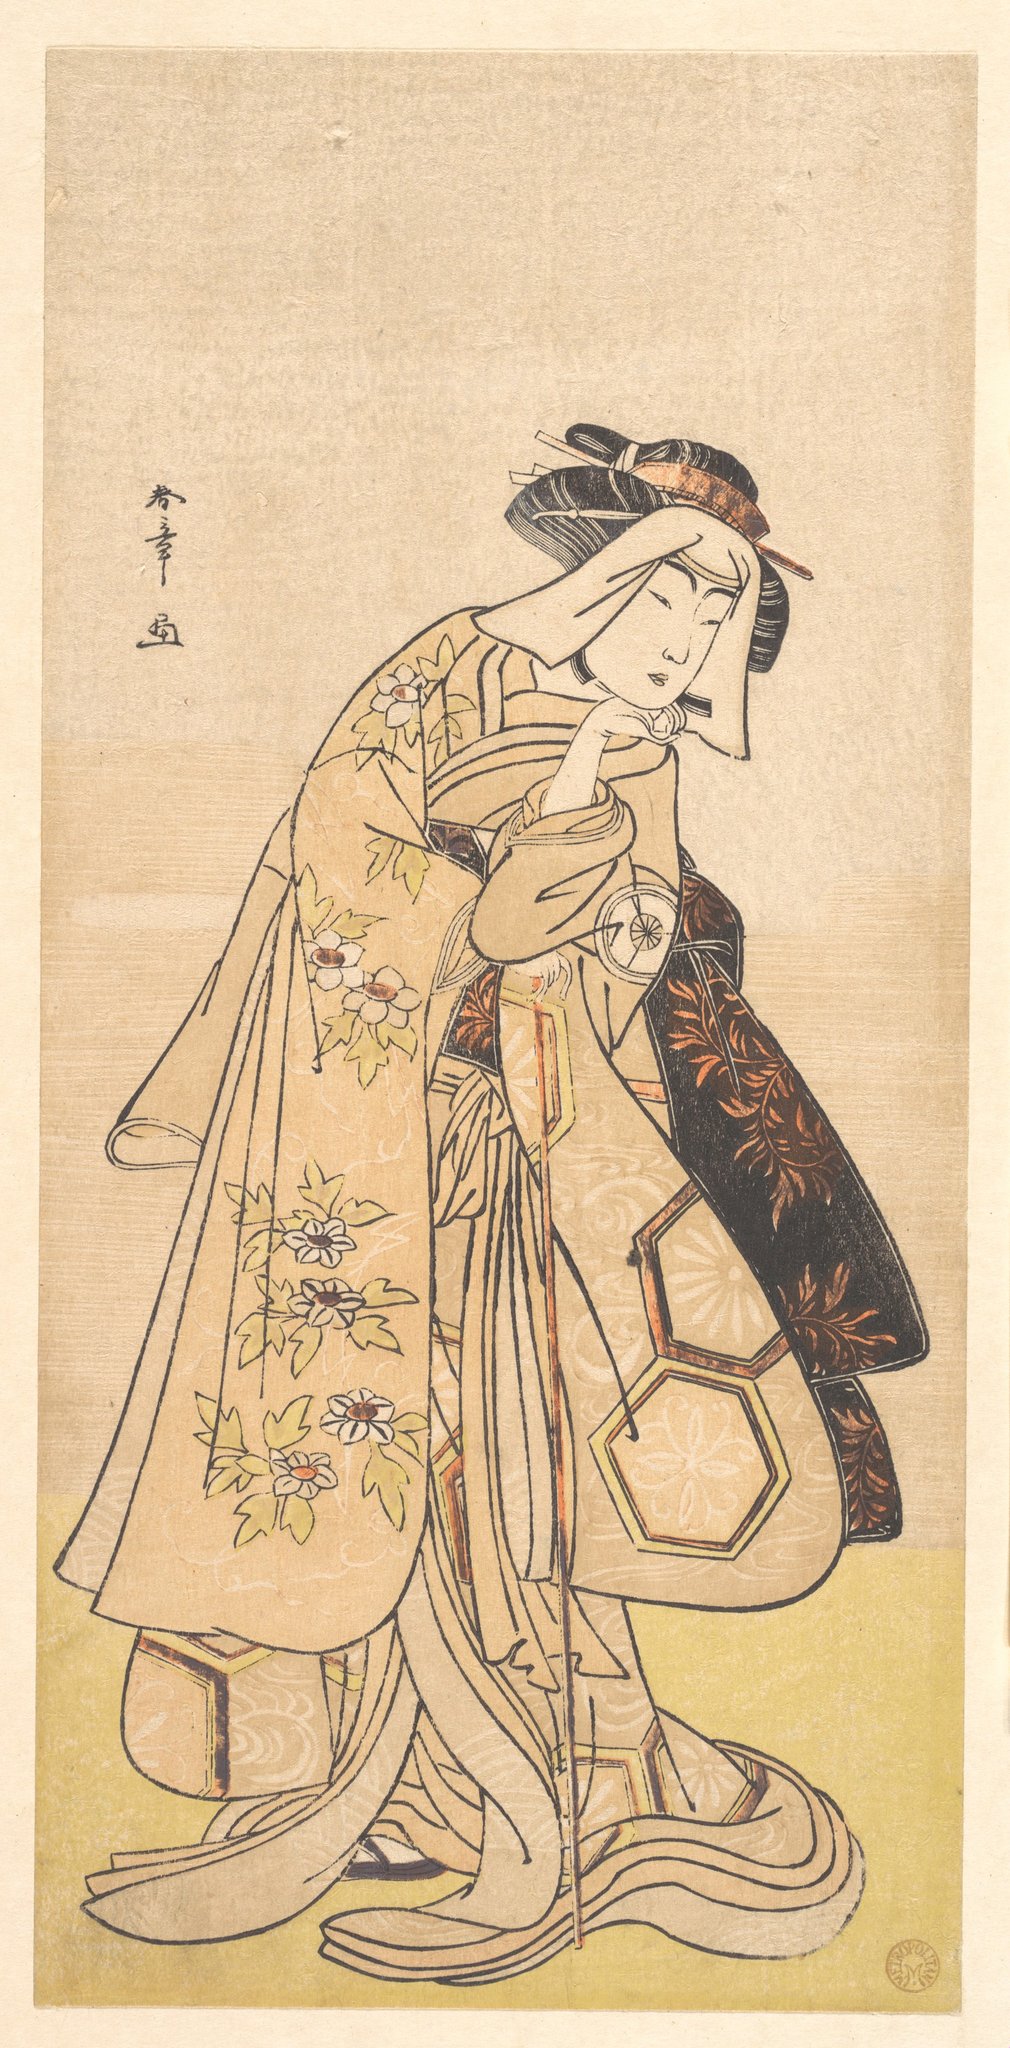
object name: woodblock print nishiki e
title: The Fourth Iwai Hanshirō as a Woman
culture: japanese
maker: katsukawa shunshō 勝川春章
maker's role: artist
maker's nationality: japanese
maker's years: 1726-1792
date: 1779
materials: ink, paper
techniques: nishiki e, woodblock print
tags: men,women,actors